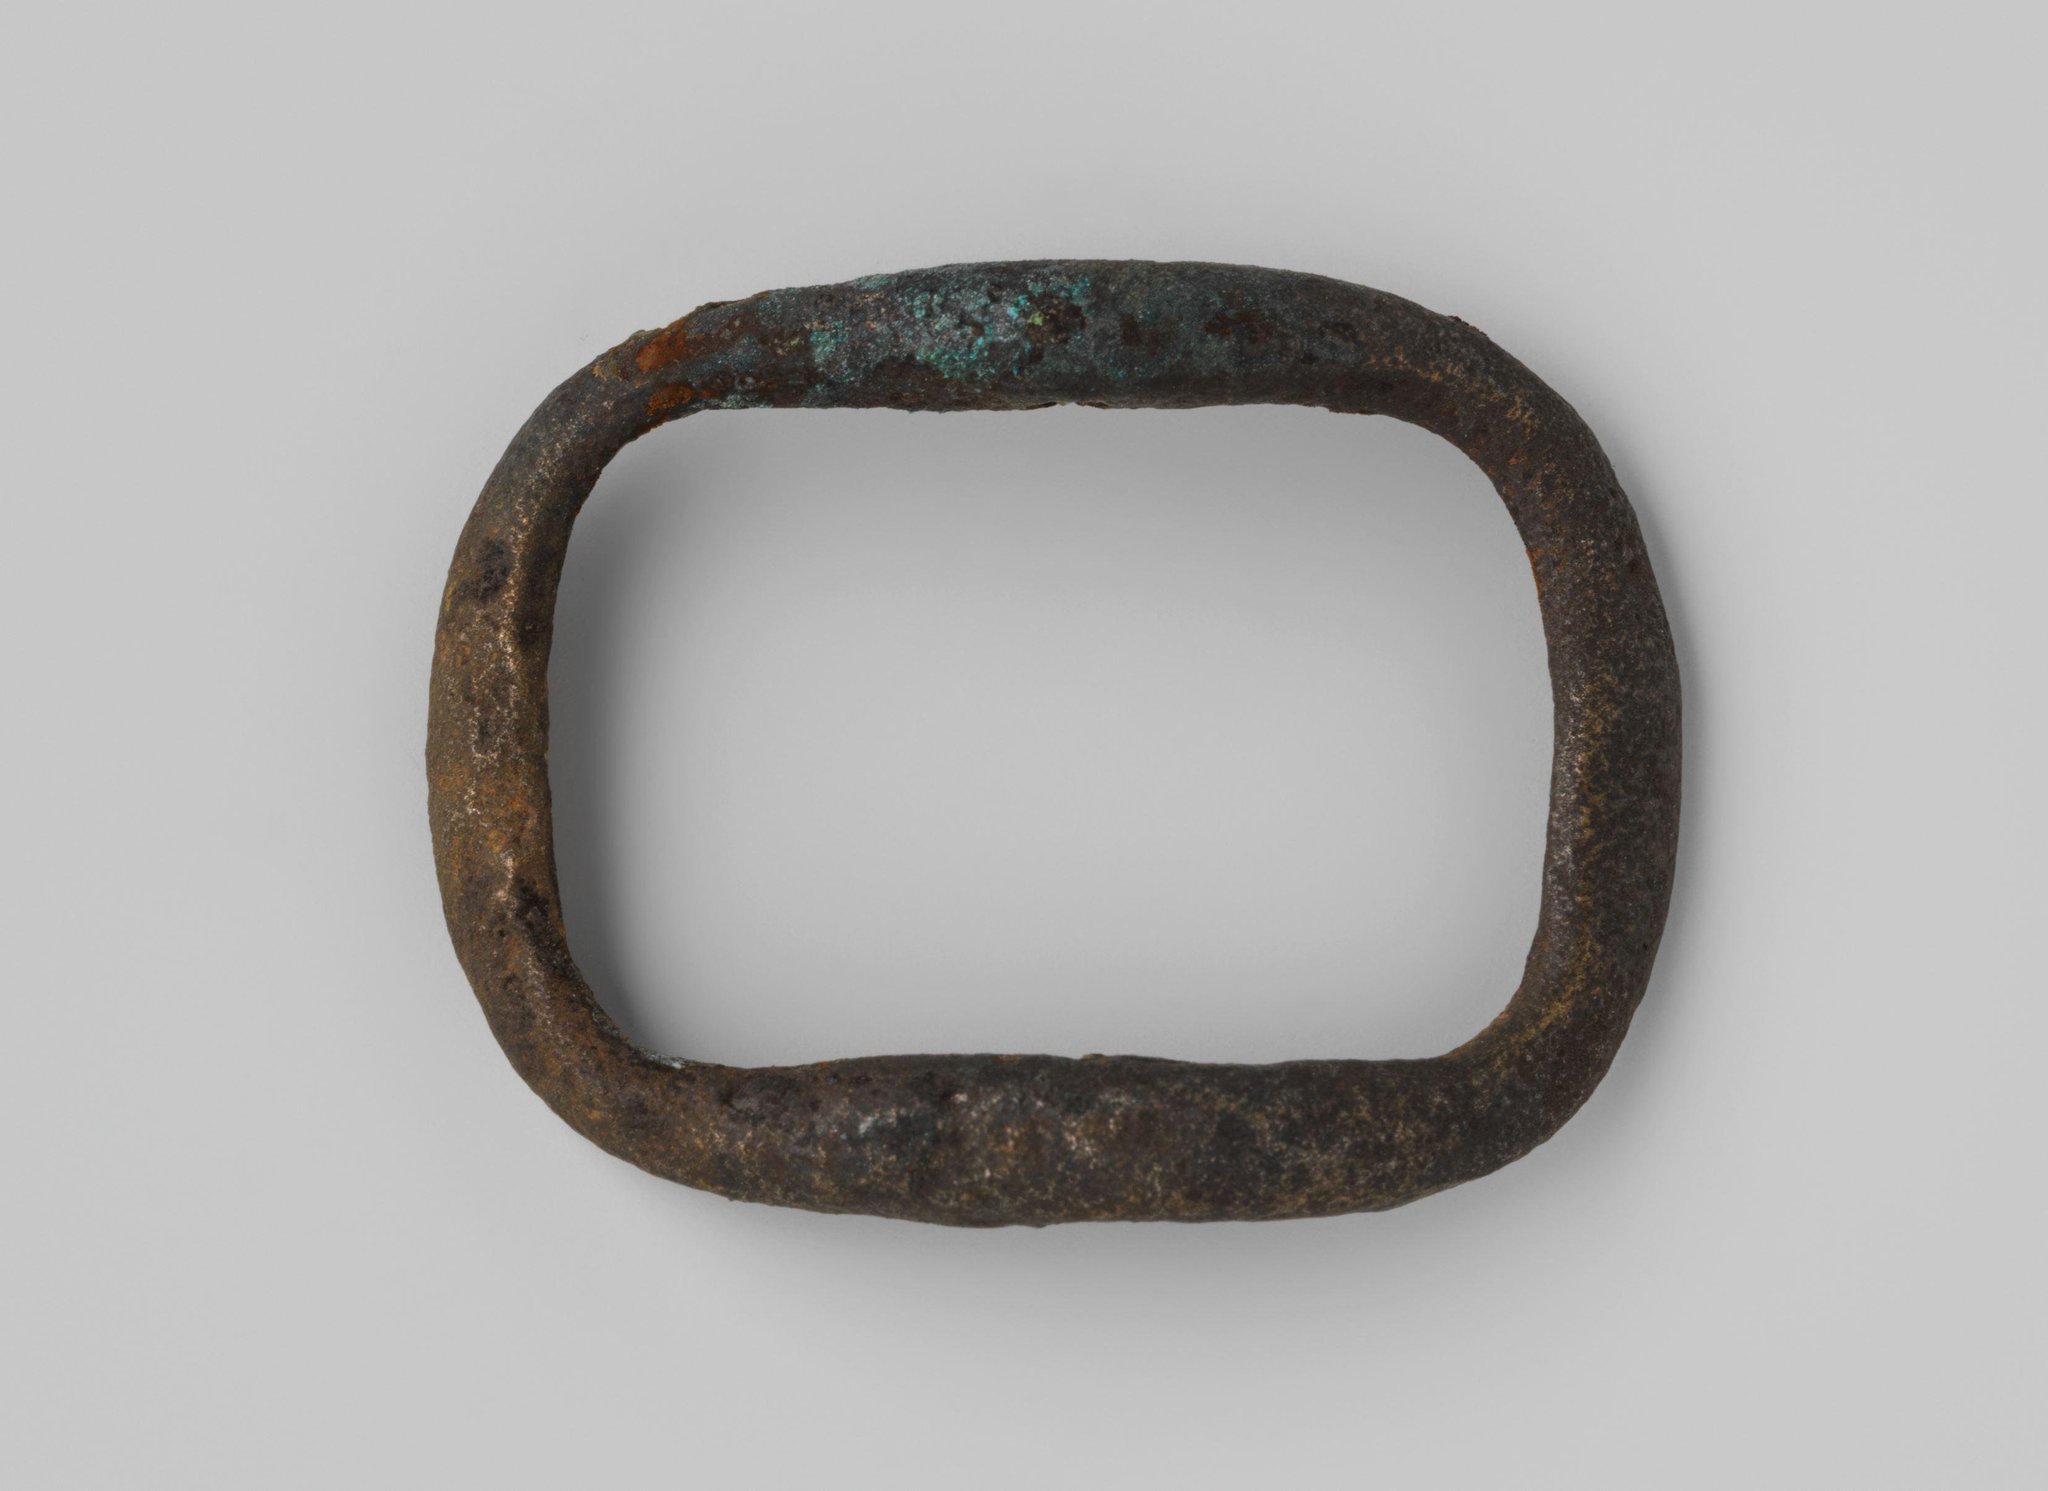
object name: shoe buckle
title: Schoengesp uit het wrak van de Oost-Indiëvaarder Hollandia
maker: Anonymous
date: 1700-1743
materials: copper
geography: netherlands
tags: verenigde oostindische compagnie, hollandia (schip), annet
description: Buckle, chape buckle, shoe buckle; ring, plain.